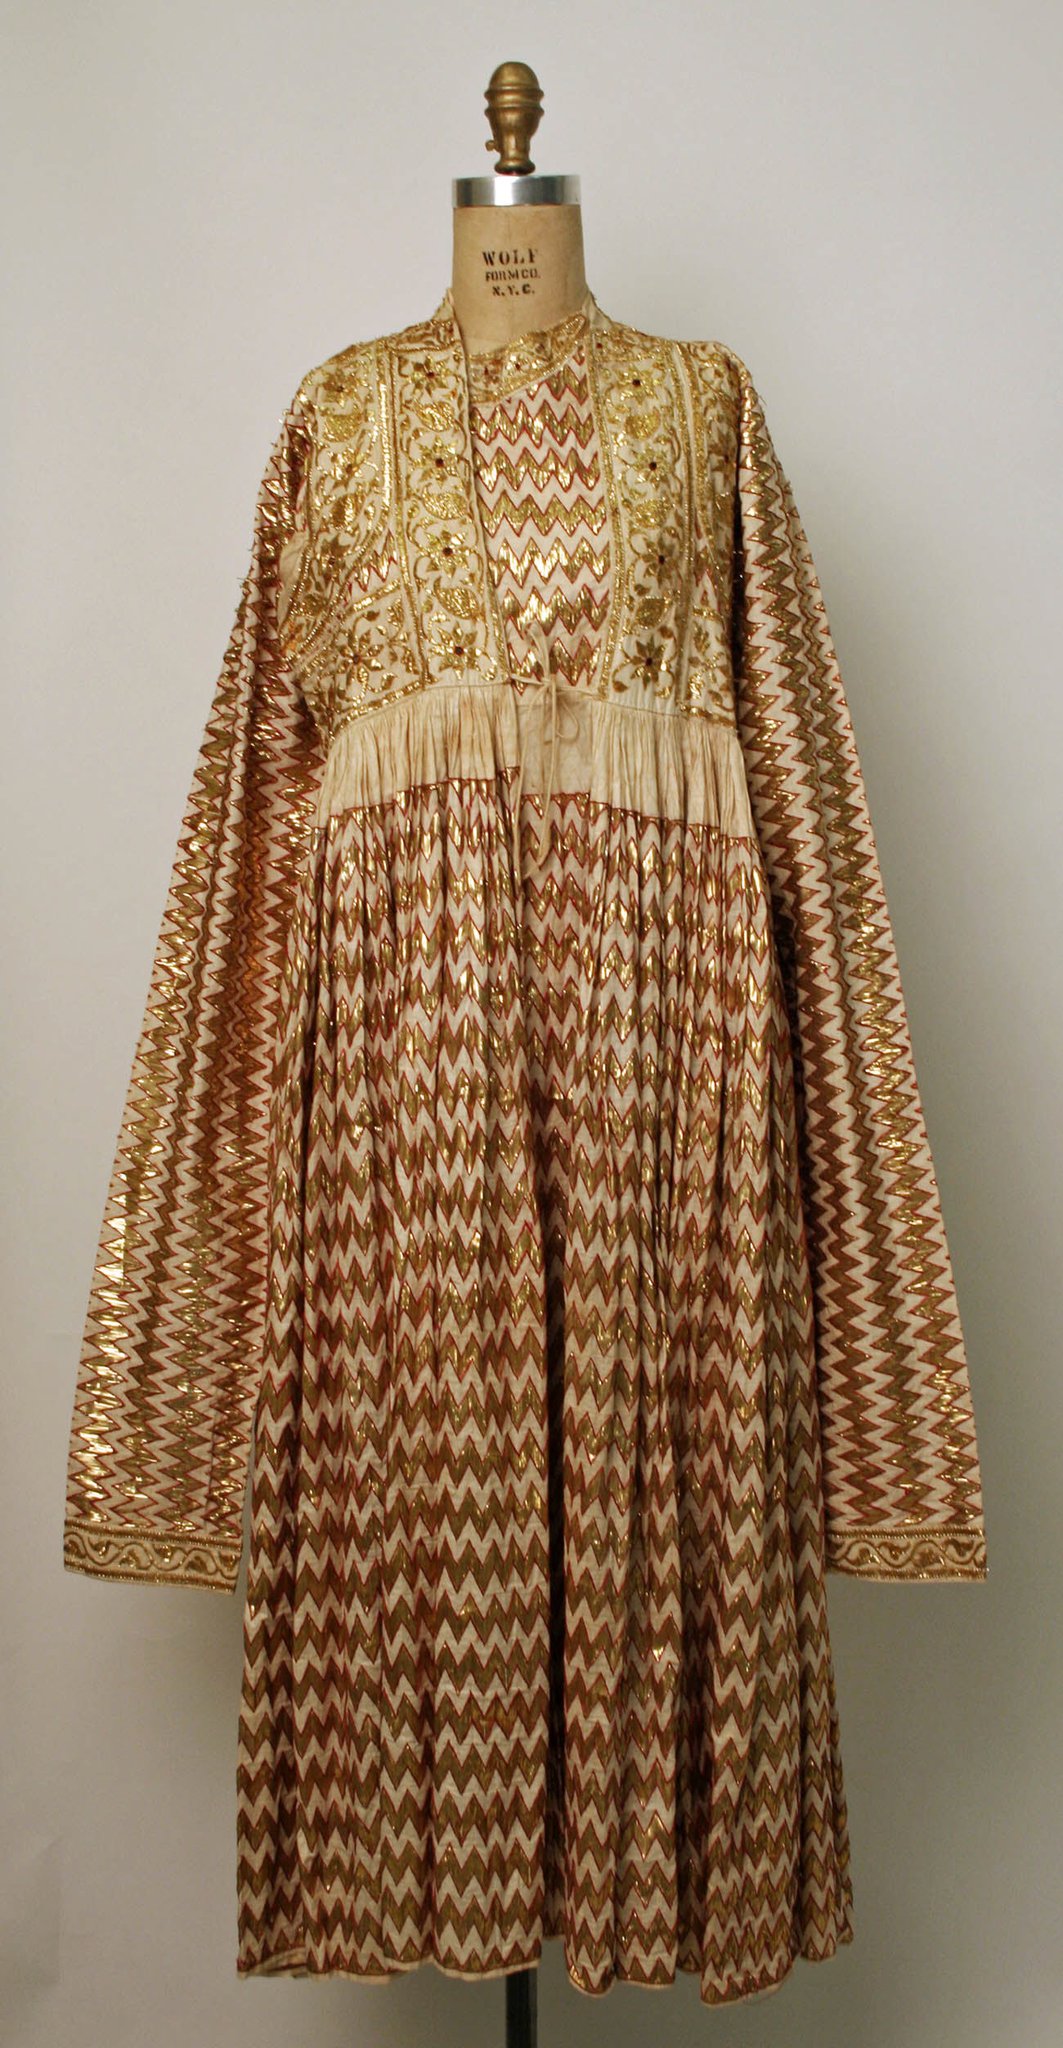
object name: coat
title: Ceremonial Coat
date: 1884-1890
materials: cotton, metal thread, silk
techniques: embroidery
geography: india